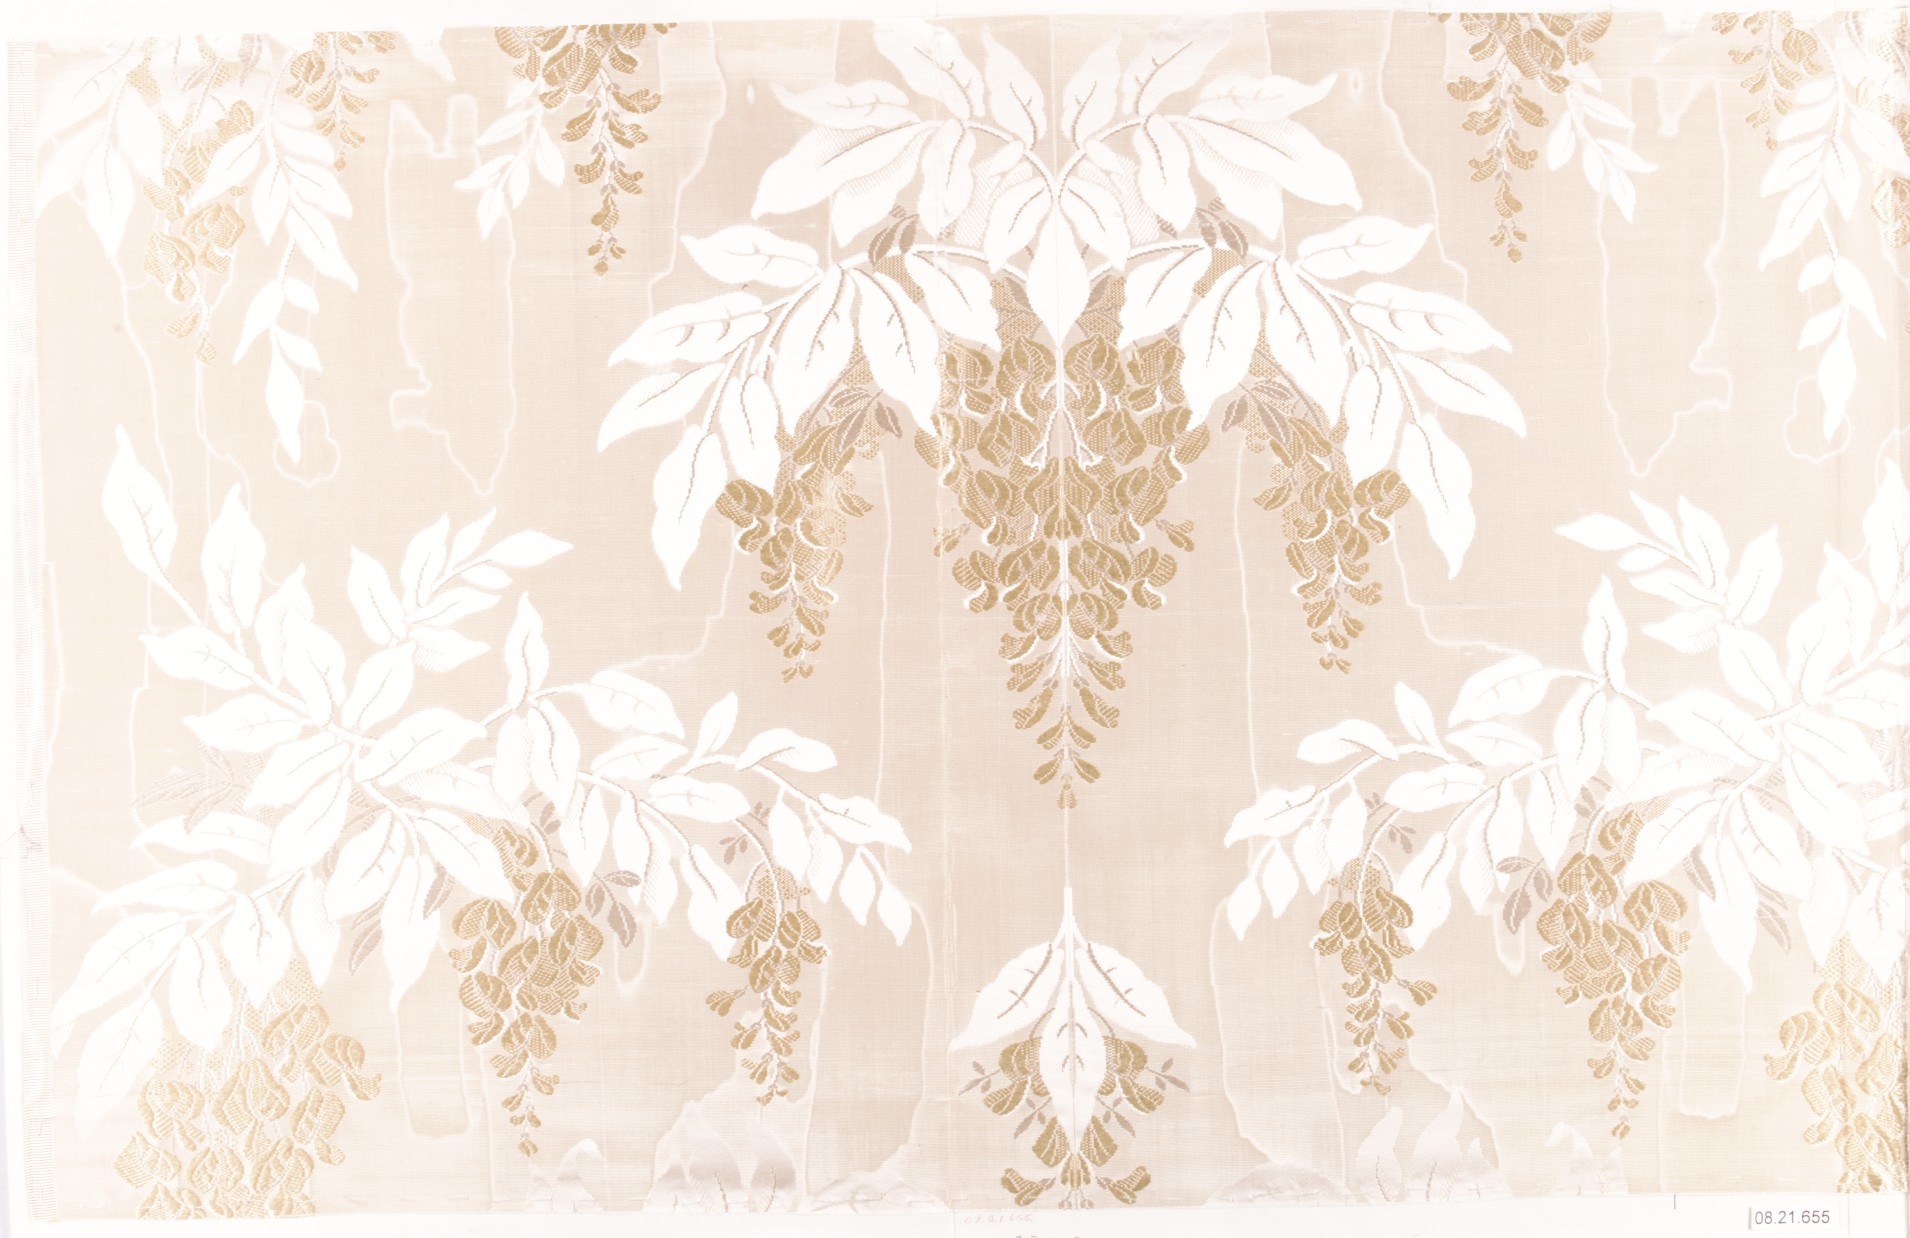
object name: textile sample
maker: Anonymous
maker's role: designer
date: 1900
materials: silk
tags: leaves